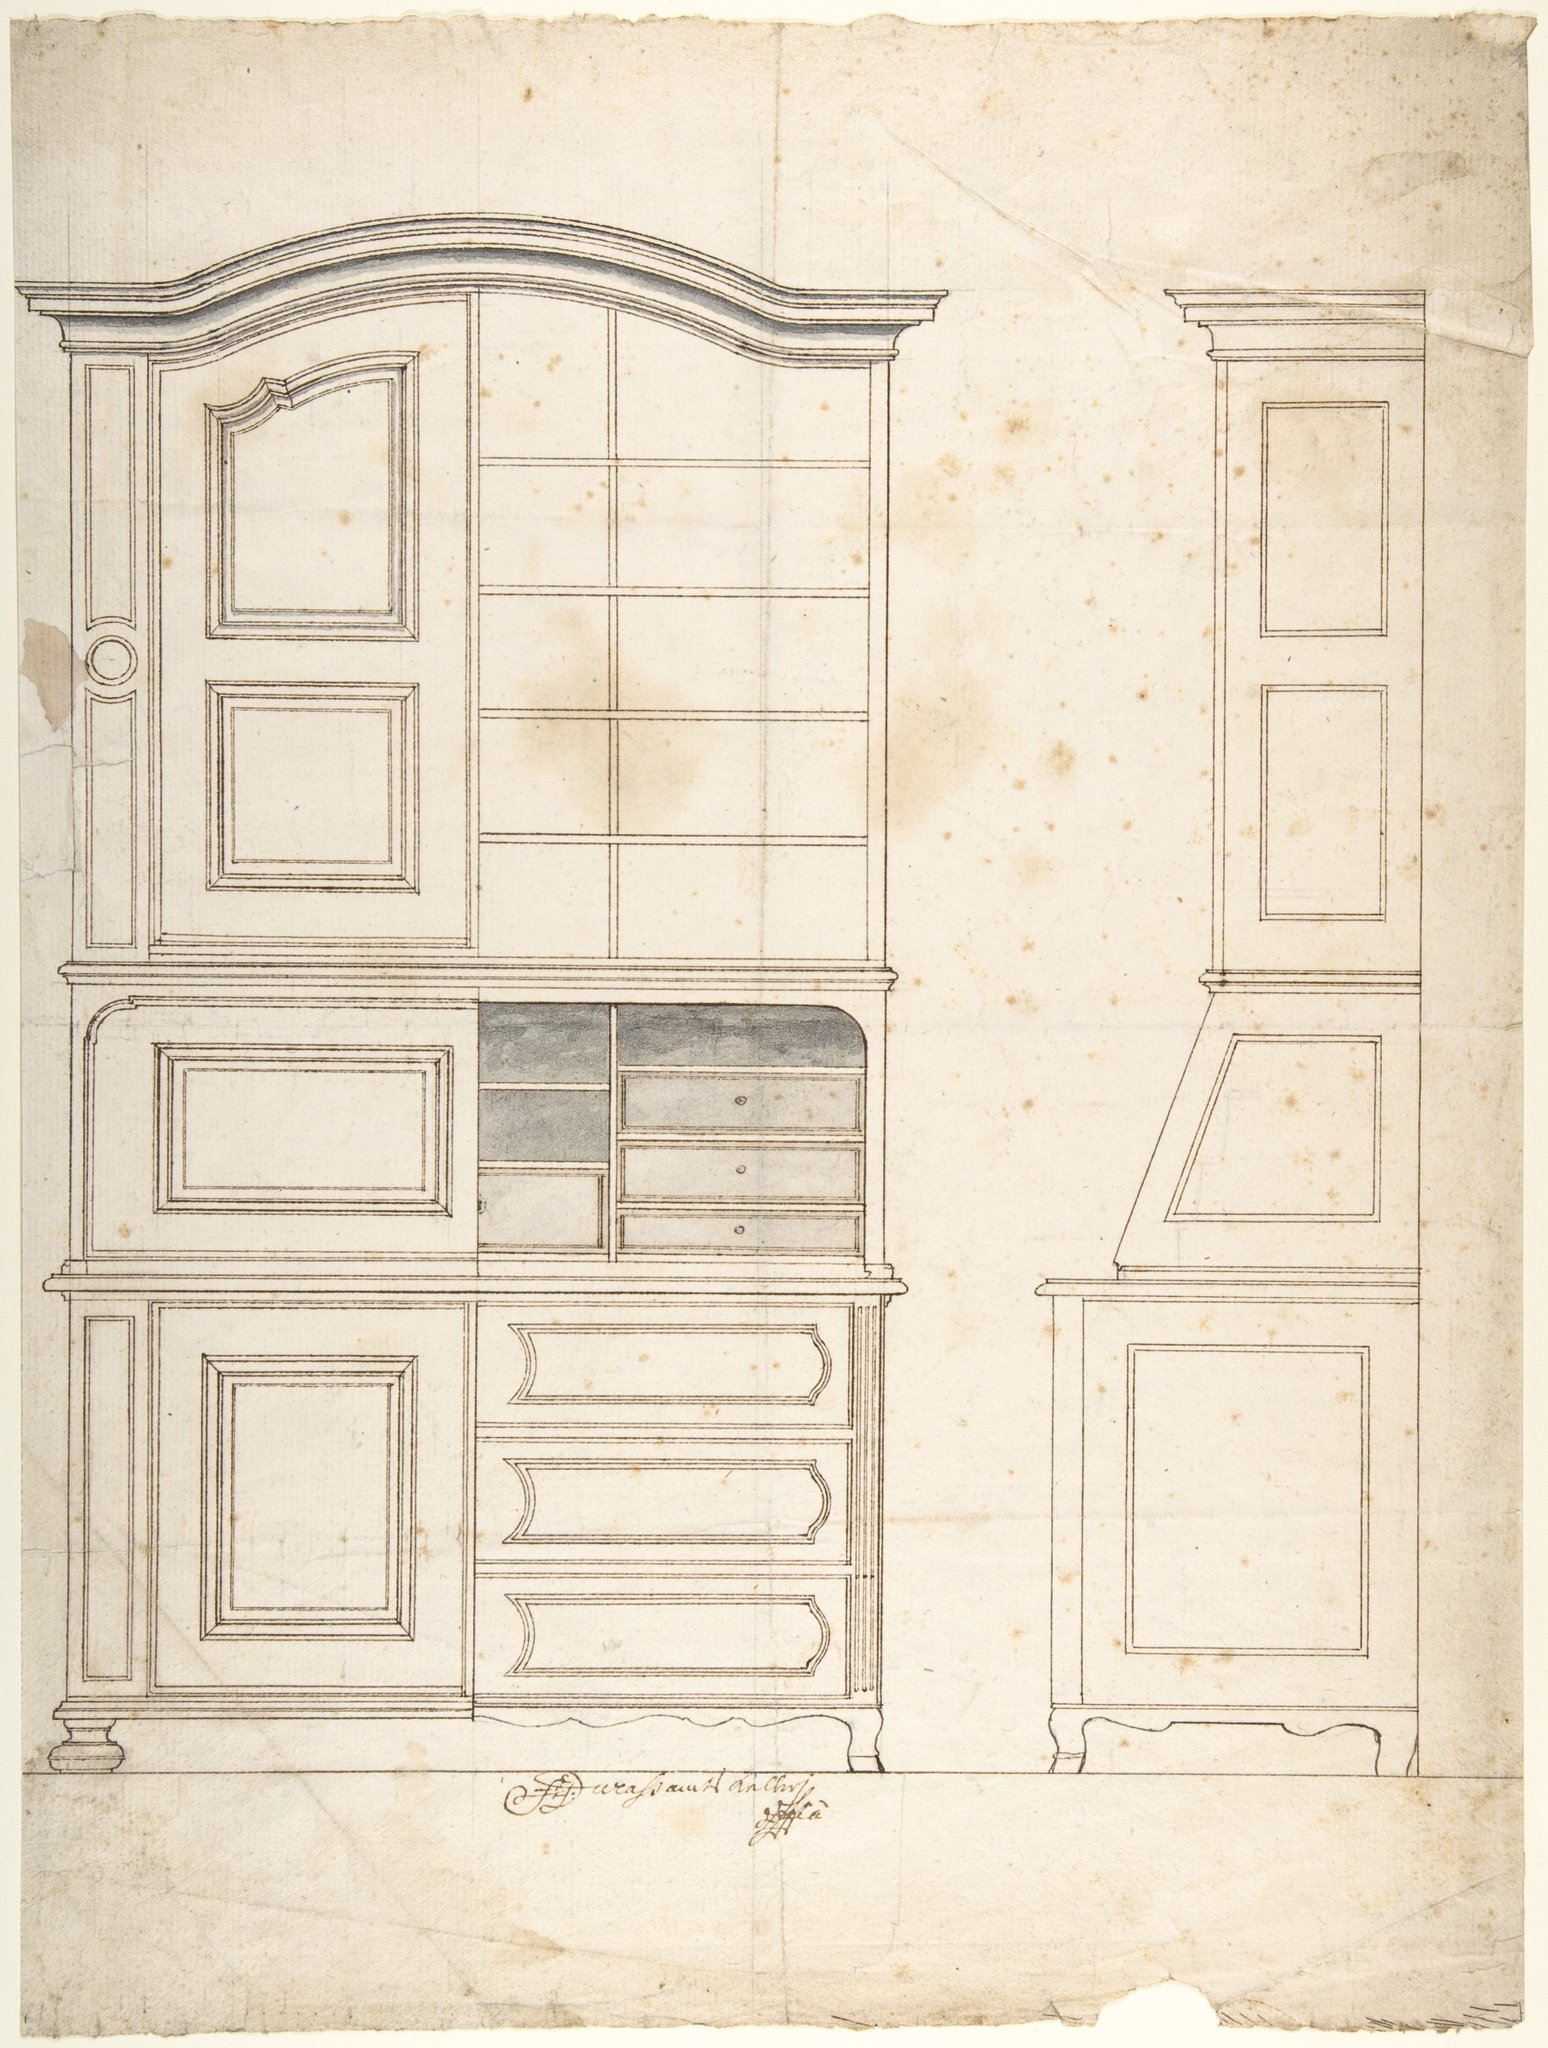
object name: drawing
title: Design for a cabinet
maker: anonymous, 18th century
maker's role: artist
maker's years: 1700-1800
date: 1701-1800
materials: ink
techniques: brush, pen, wash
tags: cabinets